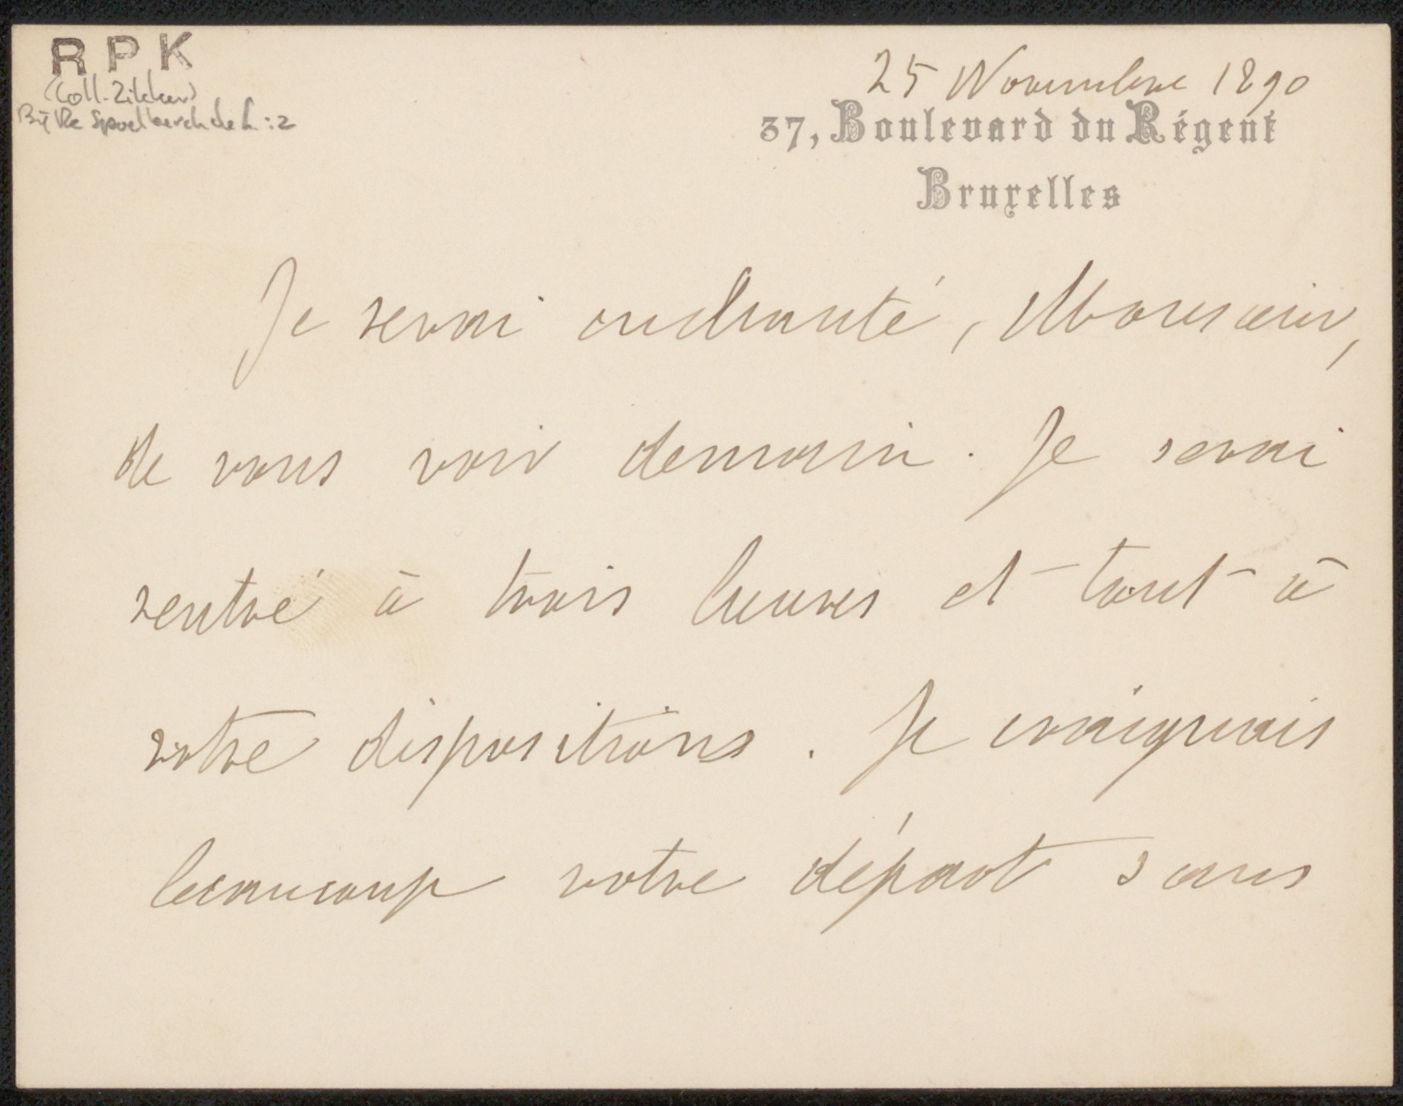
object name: letter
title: Brief aan Philip Zilcken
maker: charles vicomte de spoelberch de lovenjoul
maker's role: geleerde, schrijver, verzamelaar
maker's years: 1836-1907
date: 1890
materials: cardboard, ink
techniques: pen, printing, writing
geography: brussels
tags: the hague, painter, draughtsman, philip zilcken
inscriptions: collector's mark: ‘RPK’